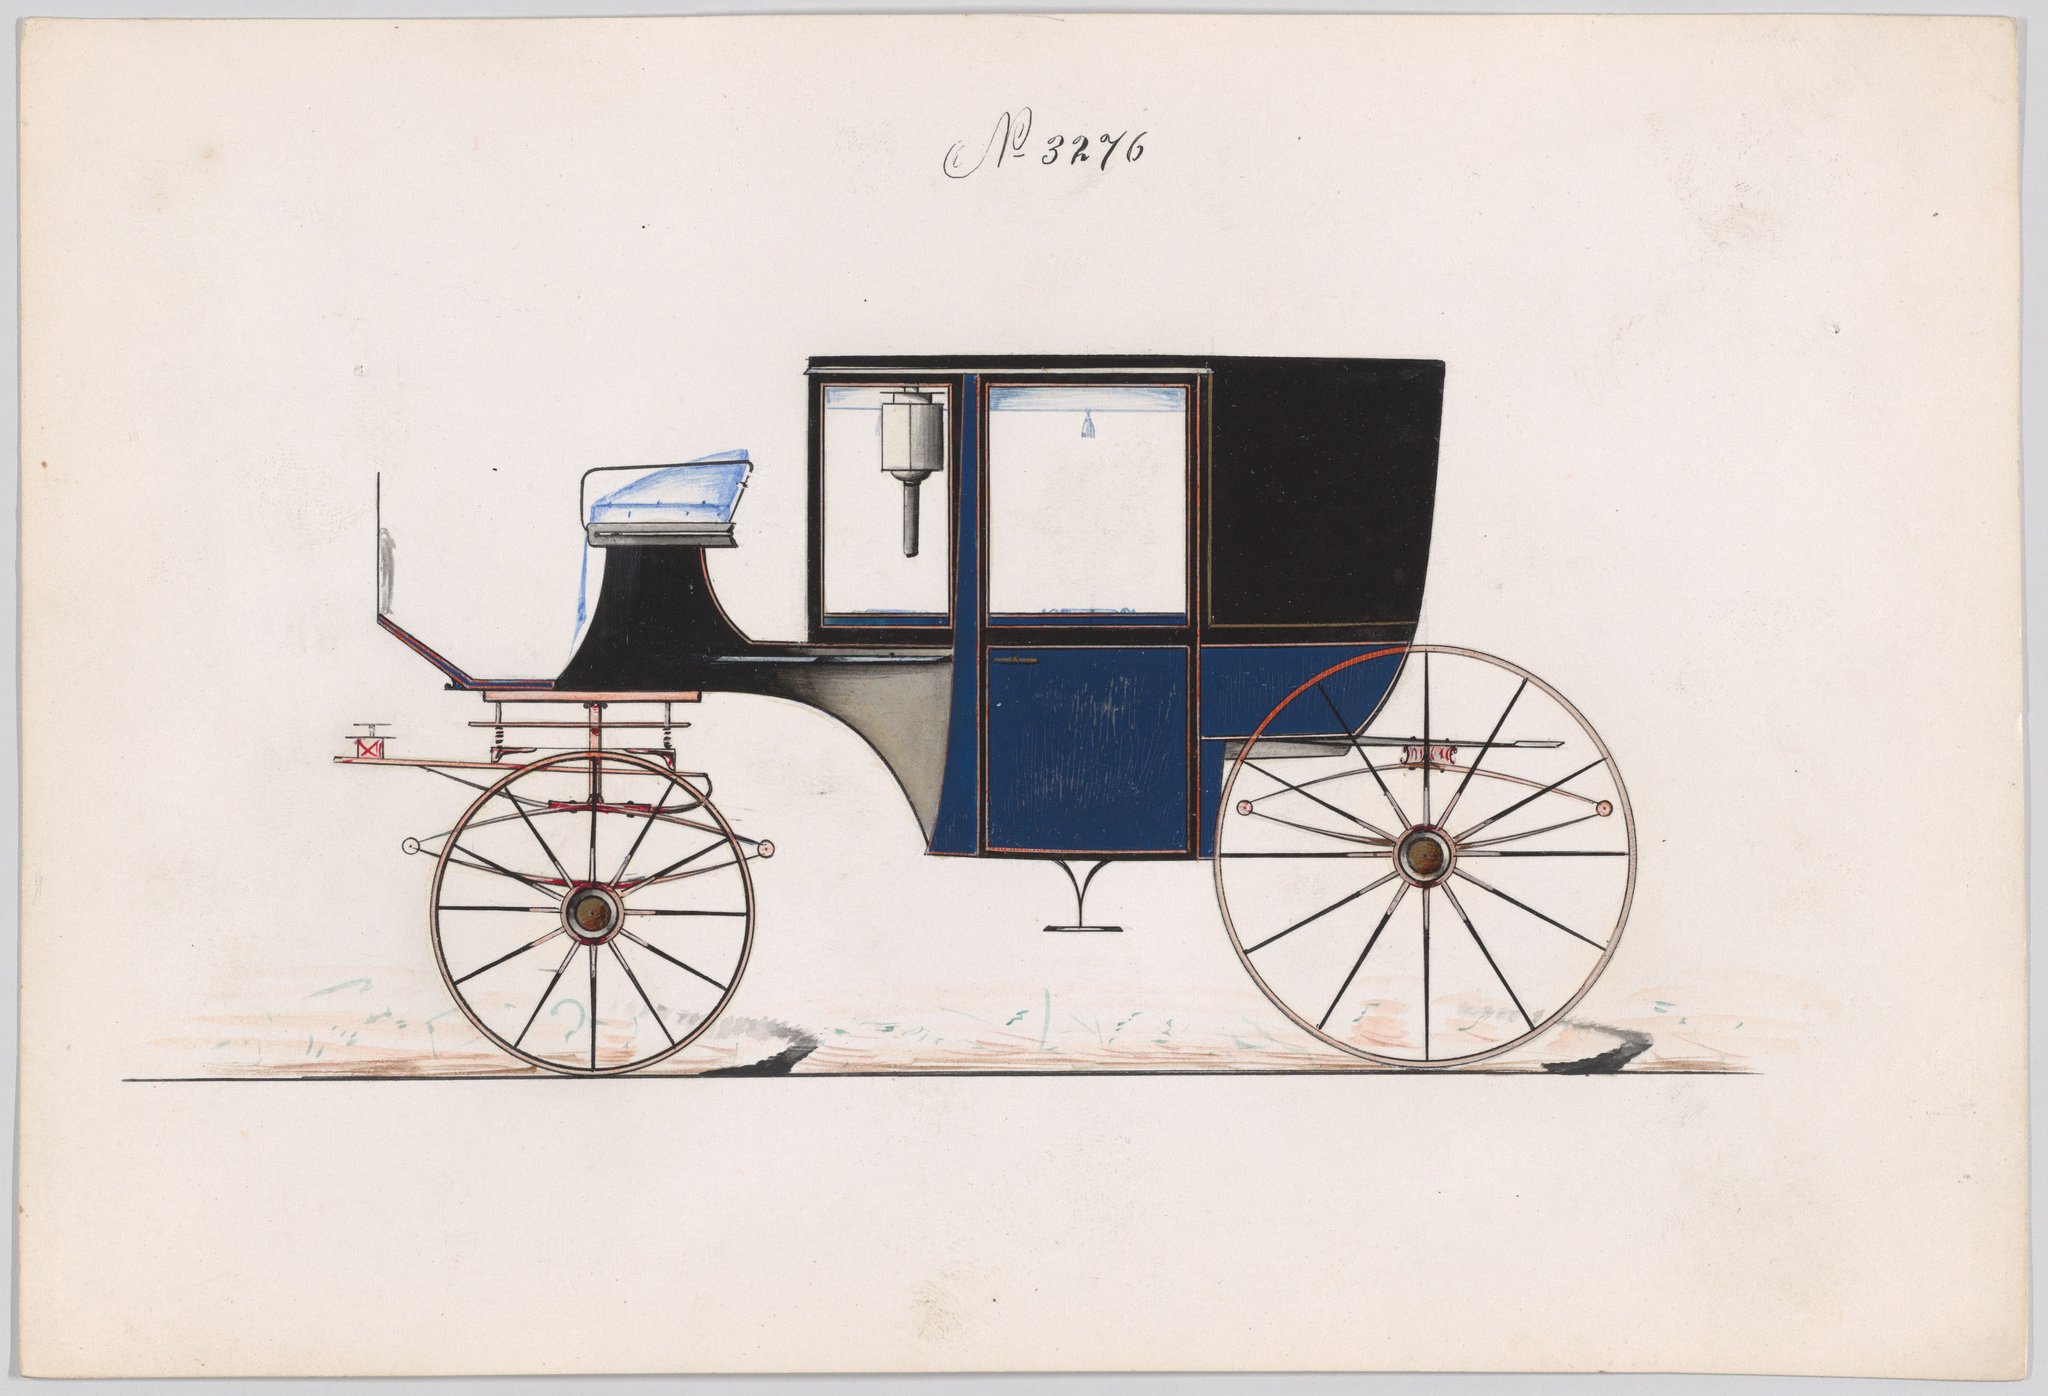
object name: drawing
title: Design for Coupé, no. 3276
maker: brewster & co.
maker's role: manufacturer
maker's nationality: american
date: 1876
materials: gouache, gum arabic, ink, watercolor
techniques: pen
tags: carriages